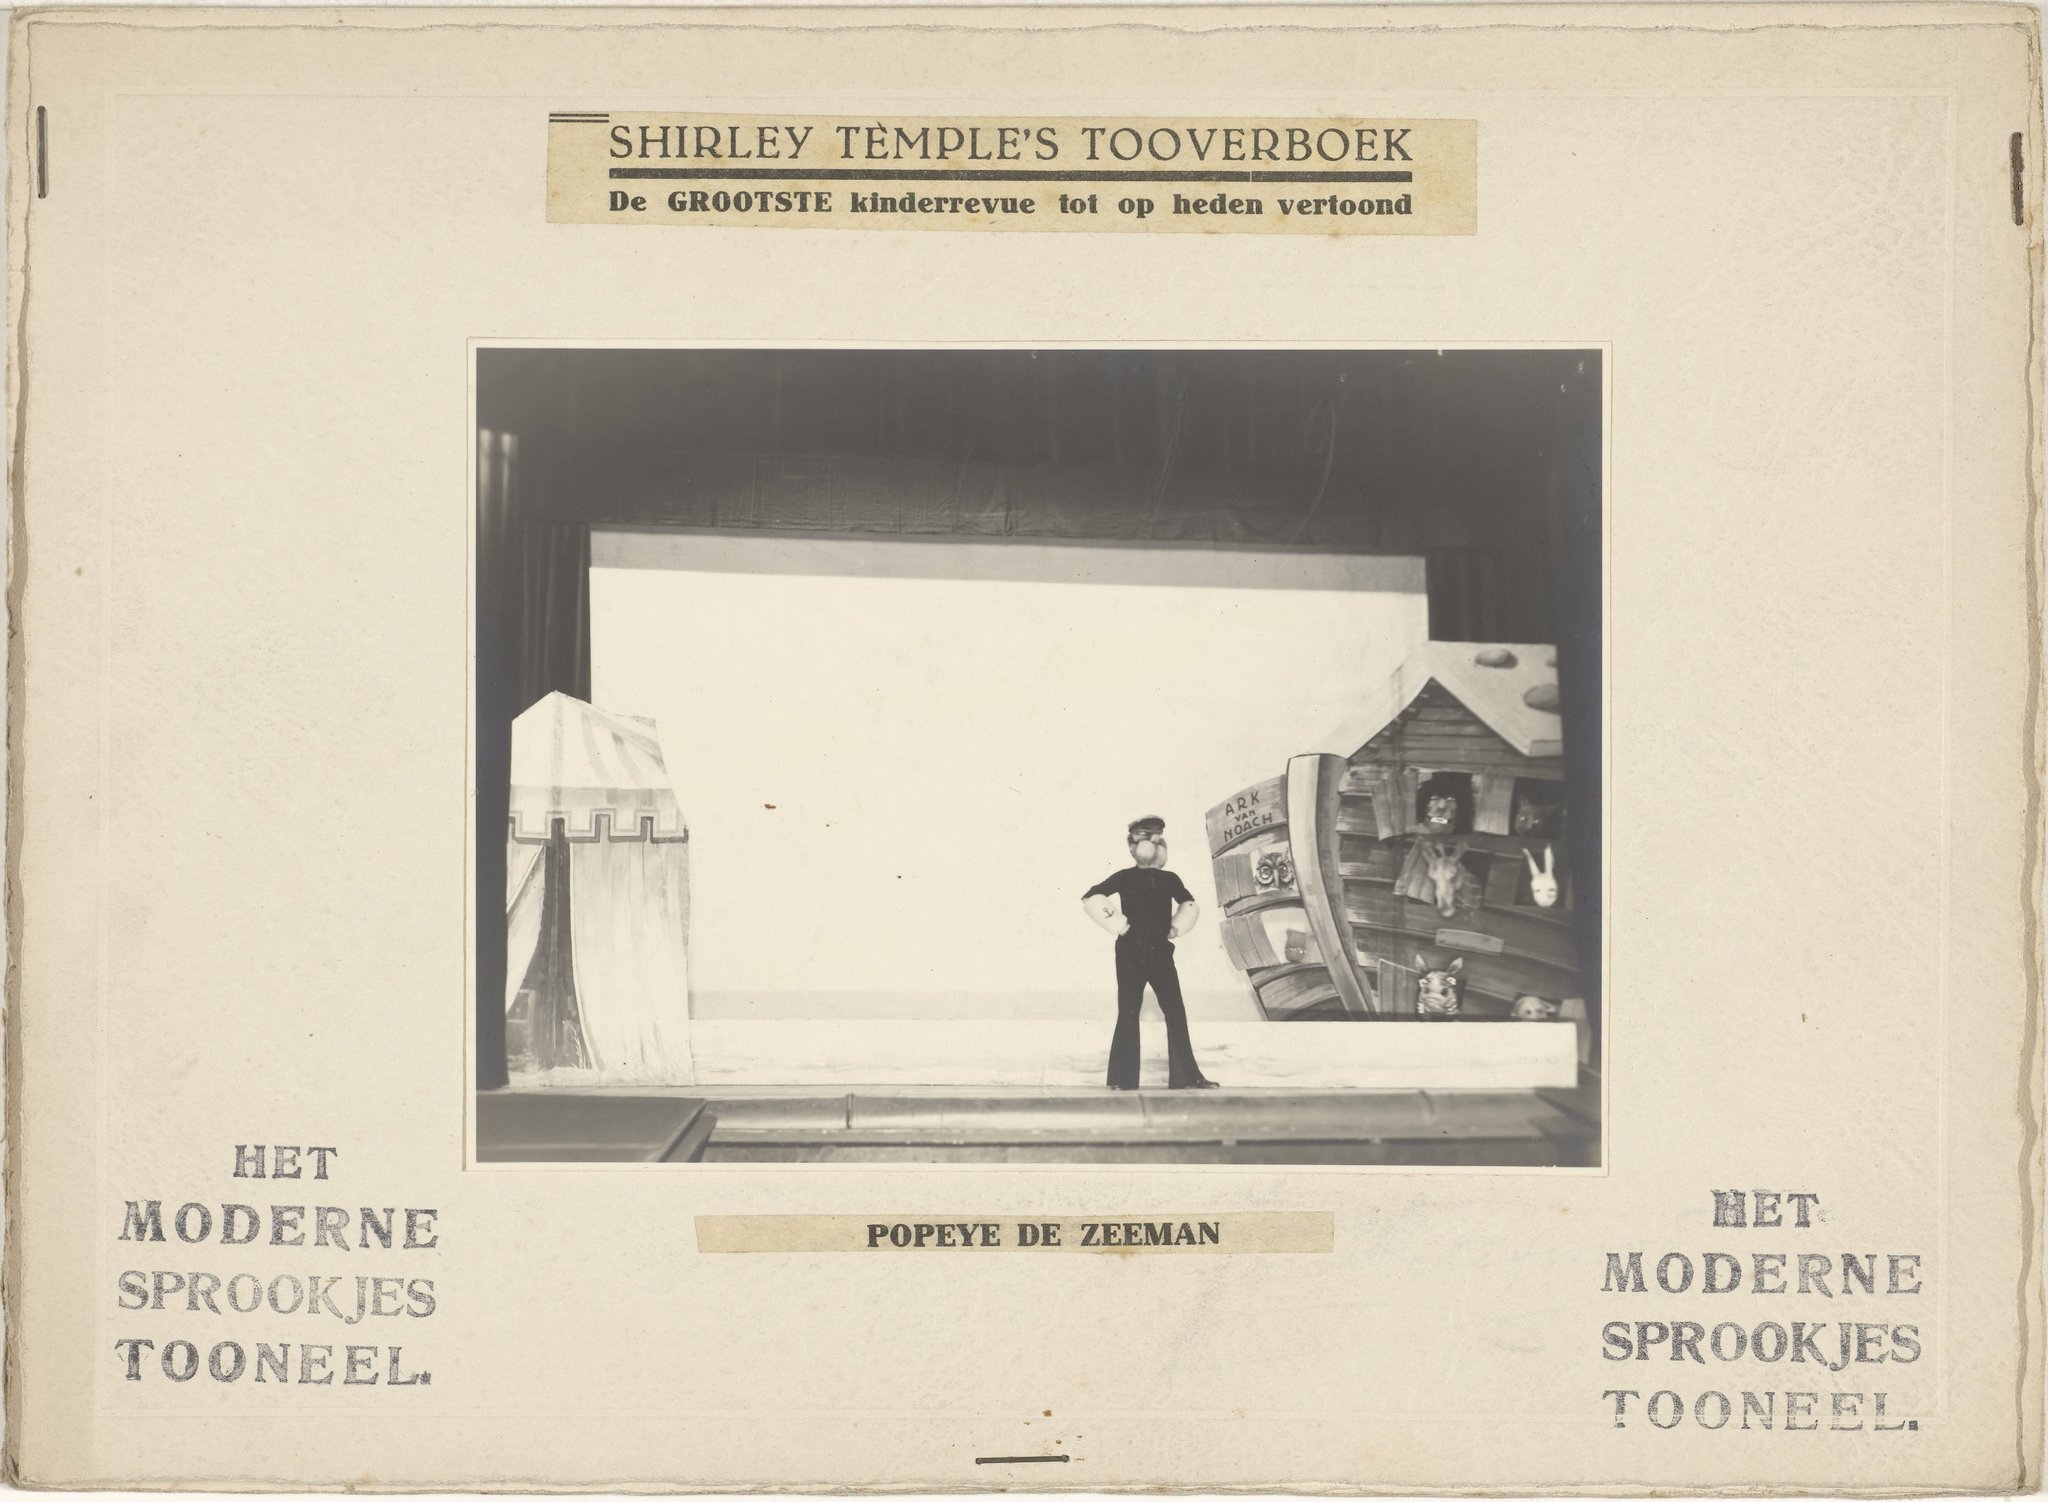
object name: photograph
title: Shirley Temple's Tooverboek, de grootste kinderrevue tot op heden vertoond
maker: Anonymous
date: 1927-1935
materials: cardboard, photographic support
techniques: gelatin silver print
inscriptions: stamp: ‘het moderne sprookjestoneel’